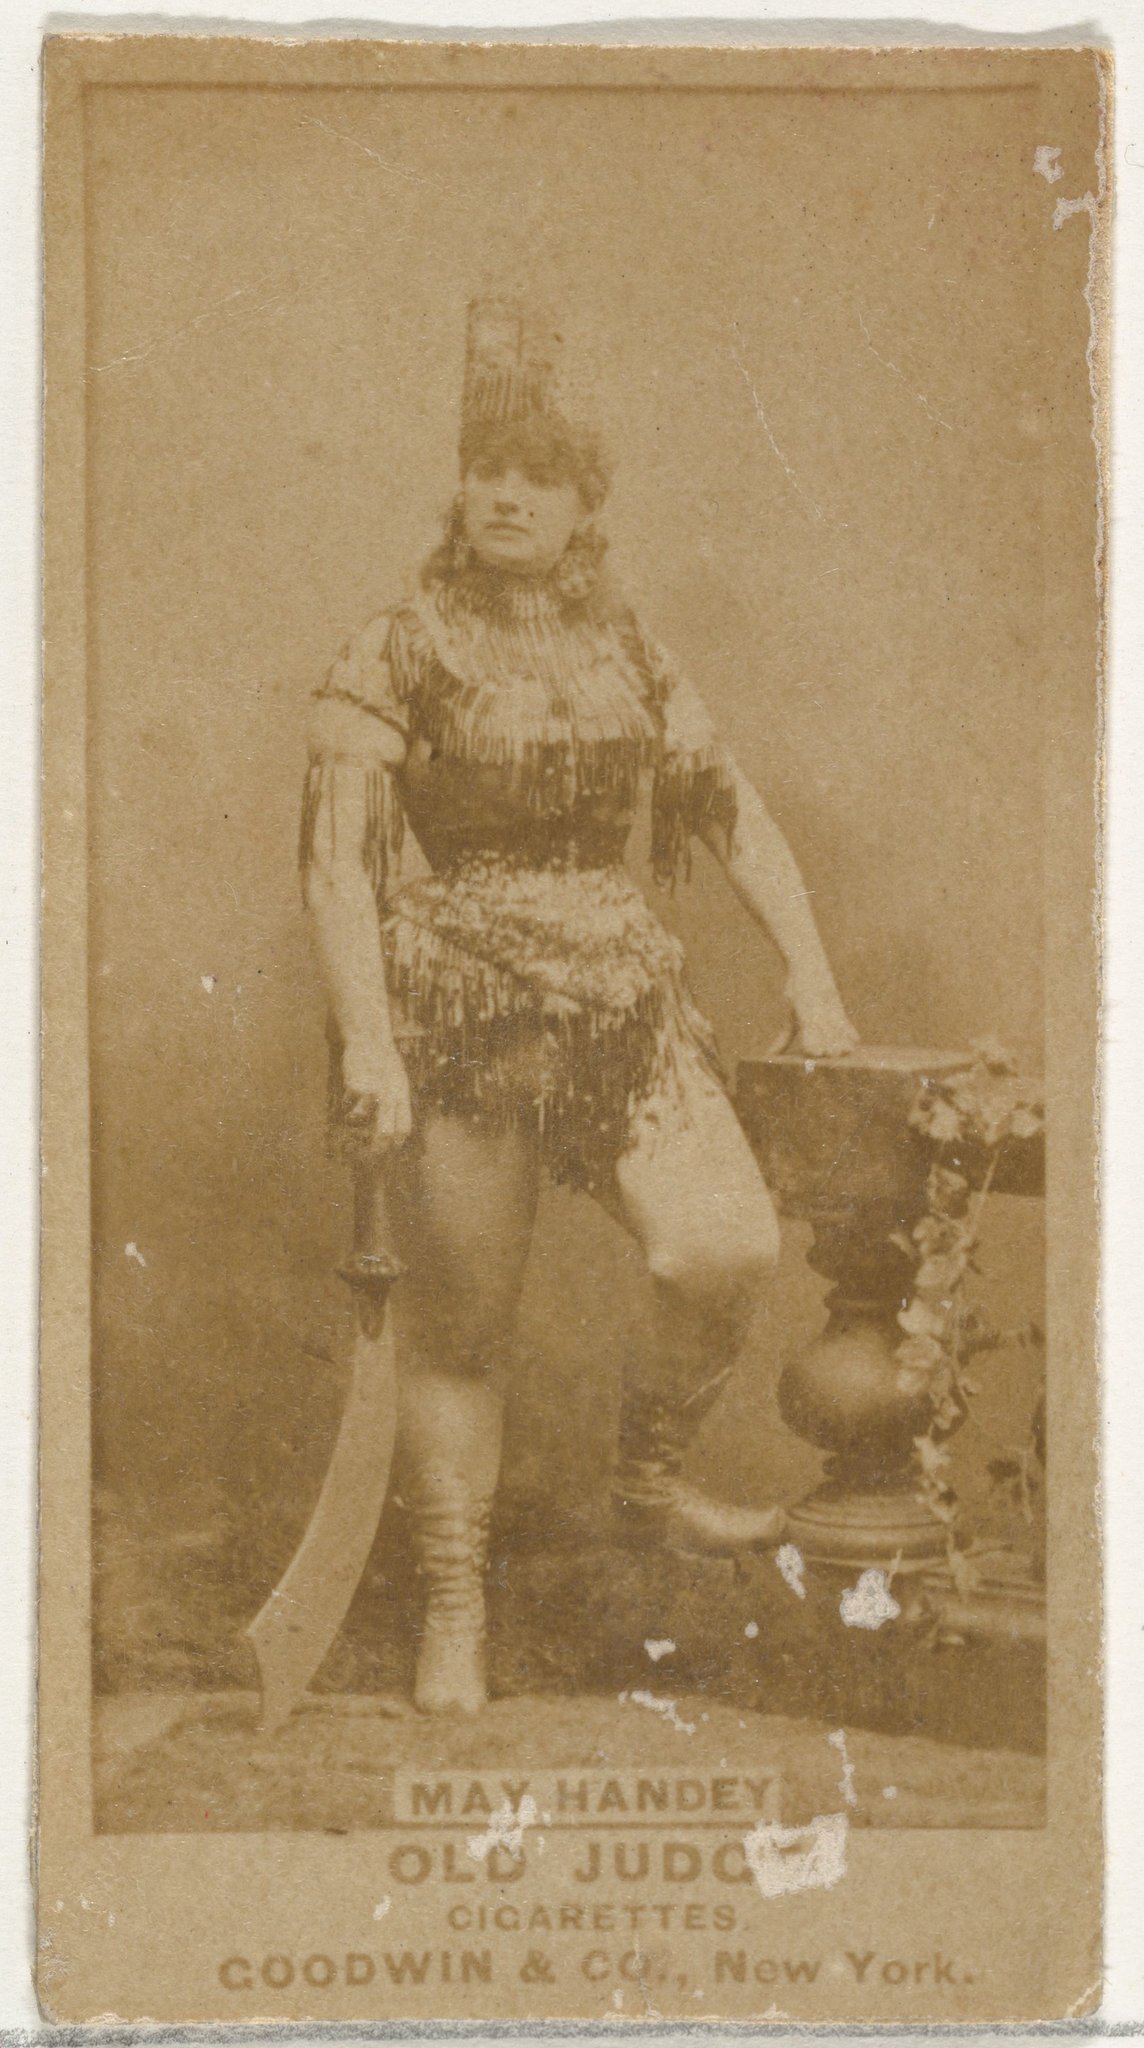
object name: photograph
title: May Handey, from the Actors and Actresses series (N171) for Old Judge Cigarettes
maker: goodwin & company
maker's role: publisher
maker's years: 1850-1950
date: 1886-1890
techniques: albumen silver print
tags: portraits,women,actresses